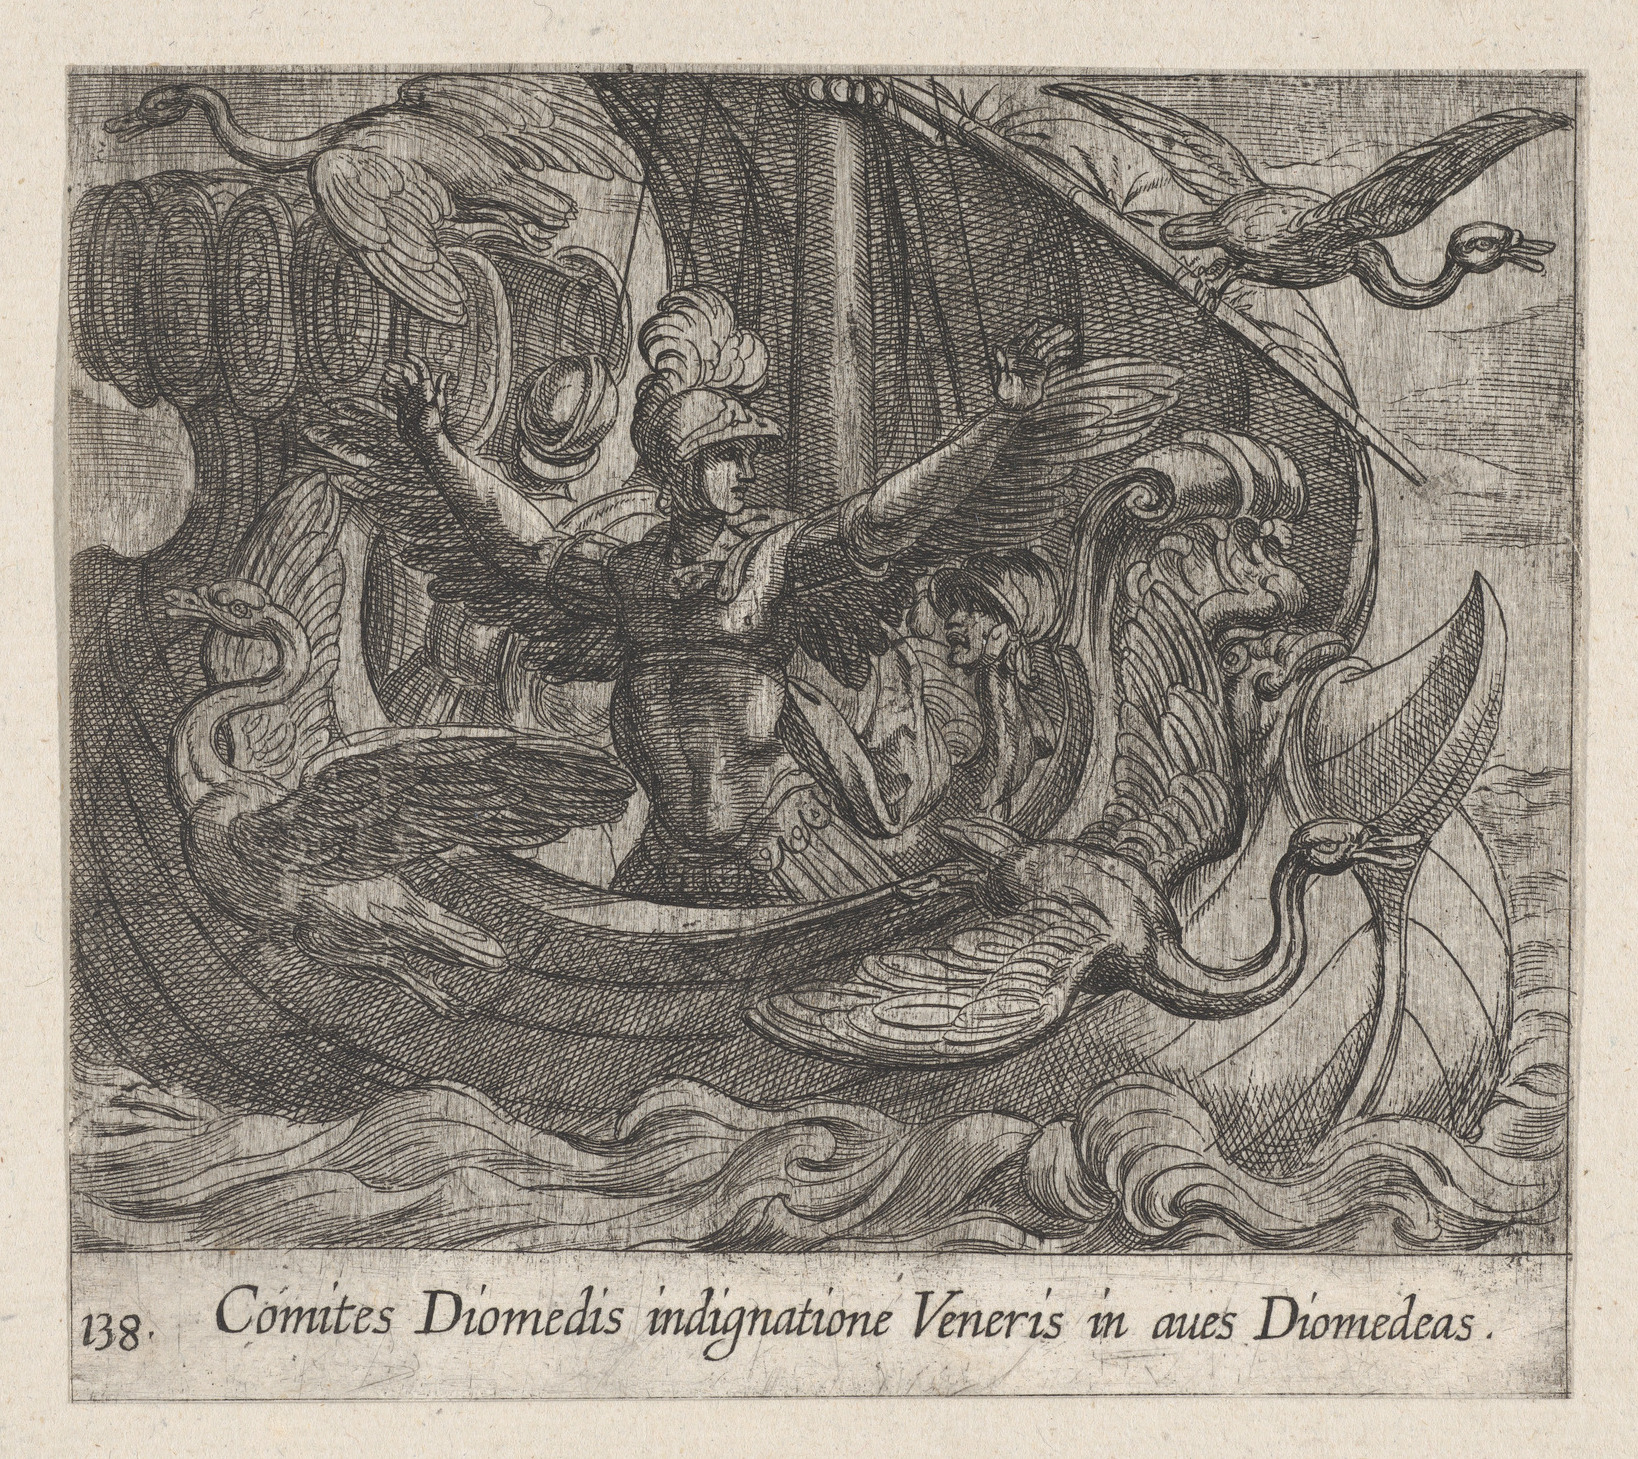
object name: print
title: Plate 138: Acmon and his Friends Changed into Birds (Comites Diomedis indignatione veneris in aves Diomedeas), from Ovid's 'Metamorphoses'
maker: antonio tempesta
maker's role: artist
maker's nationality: italian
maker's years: 1555-1630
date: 1606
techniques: etching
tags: birds